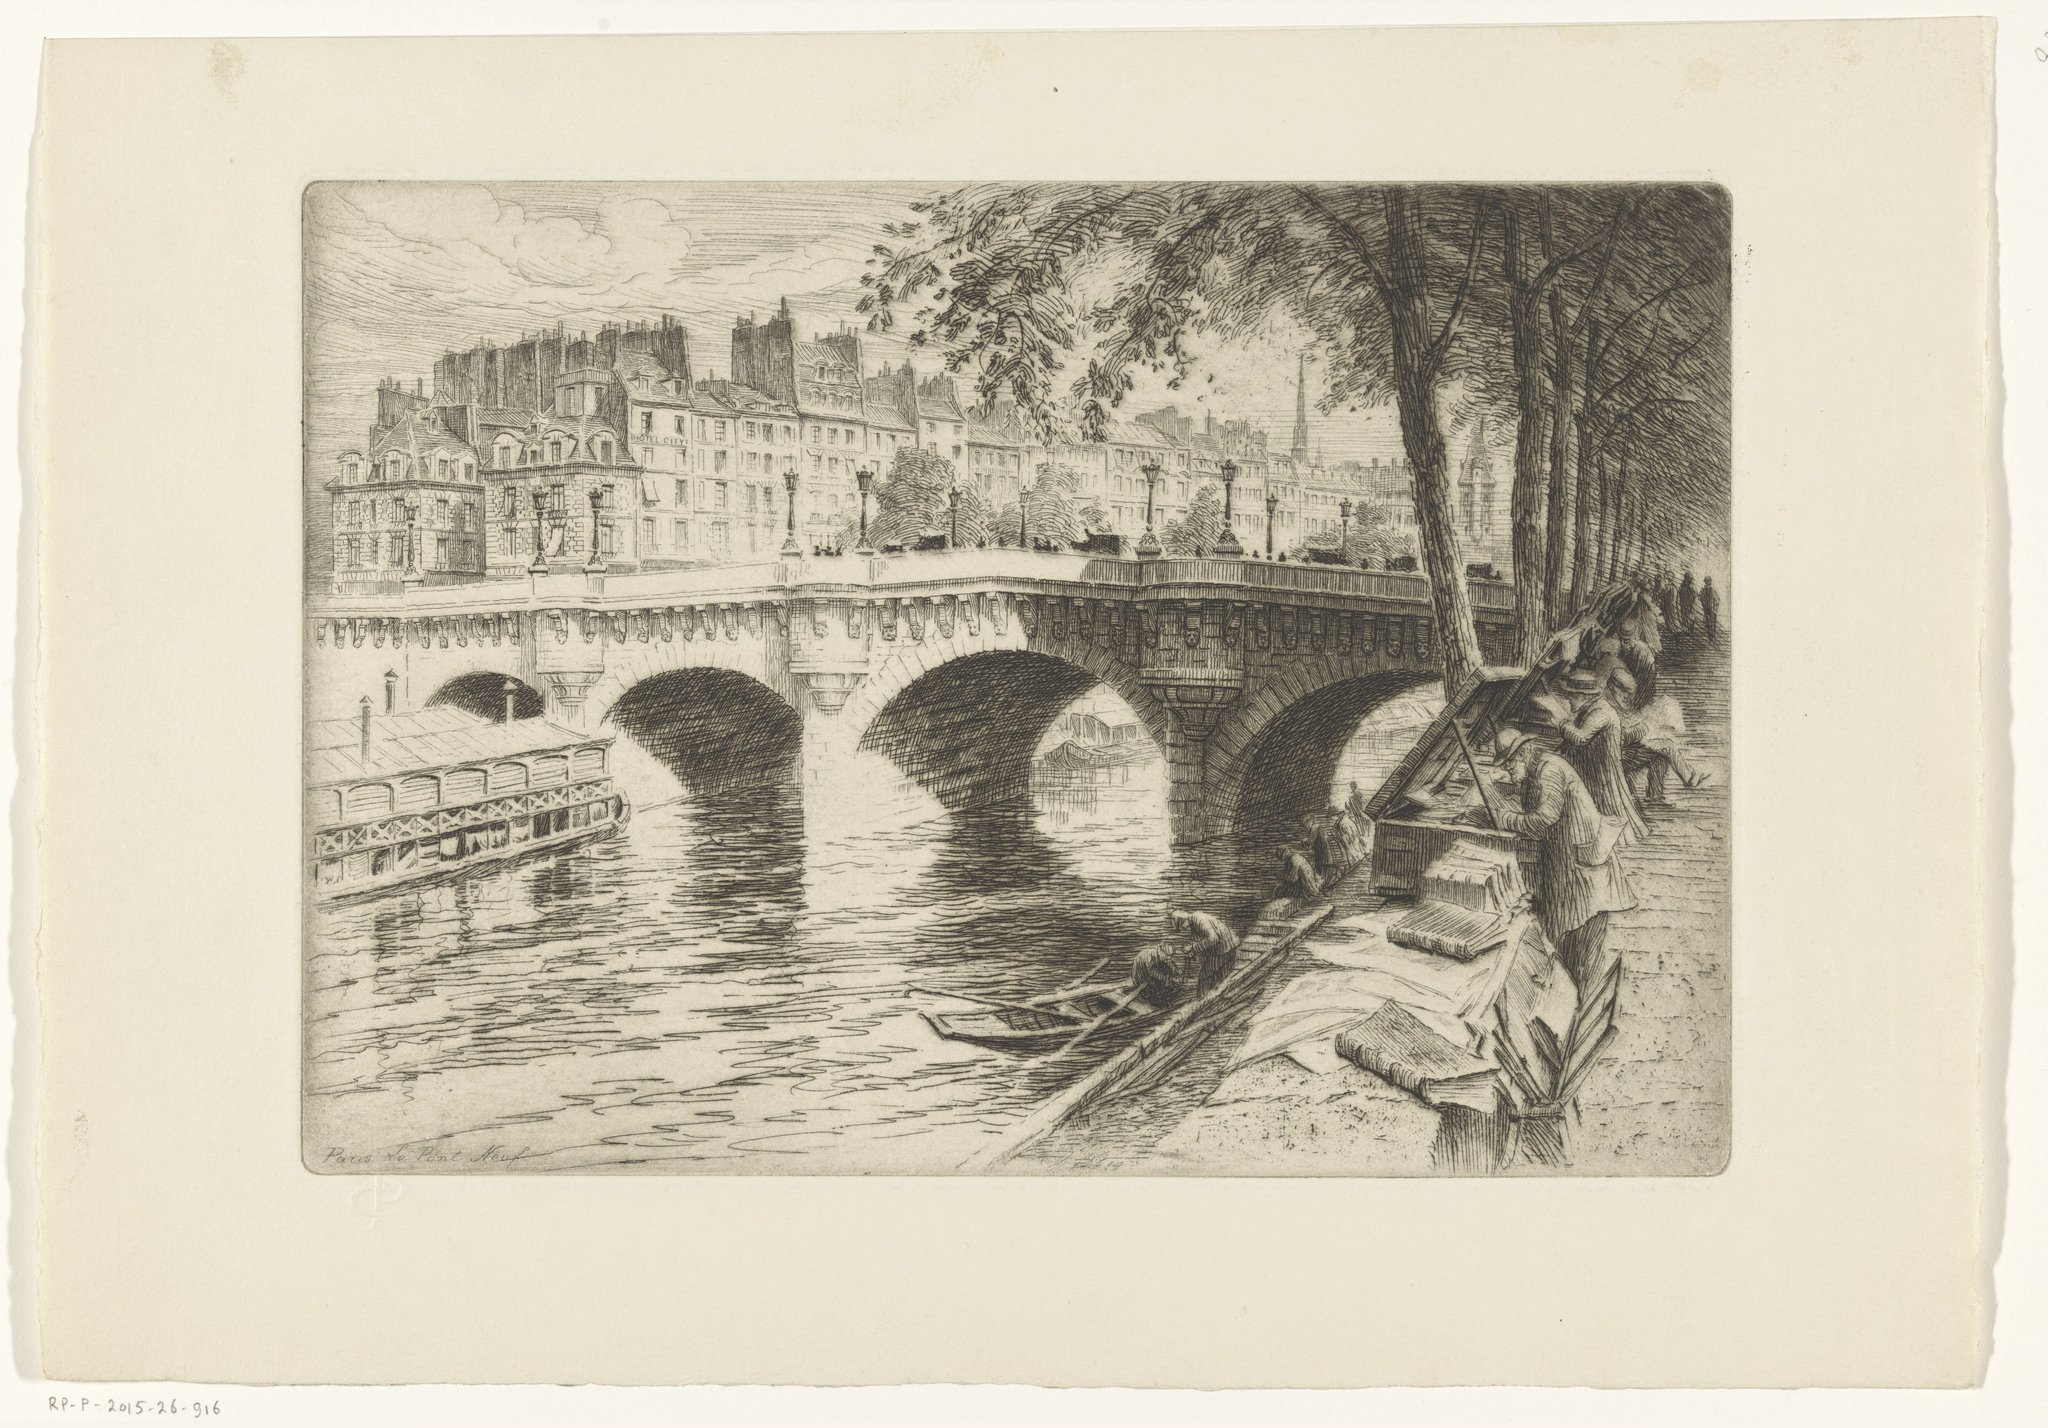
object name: print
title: Gezicht op de Pont Neuf te Parijs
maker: charles f. pinet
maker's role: print maker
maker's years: 1867-1932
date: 1877-1932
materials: paper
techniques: drypoint, etching, intaglio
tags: book-stall, kiosk, street-trader, bridge in city across river, canal, etc.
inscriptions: collector's mark: Lugt 2228, check stamp: Lugt 613h, collector's mark: Lugt 4779